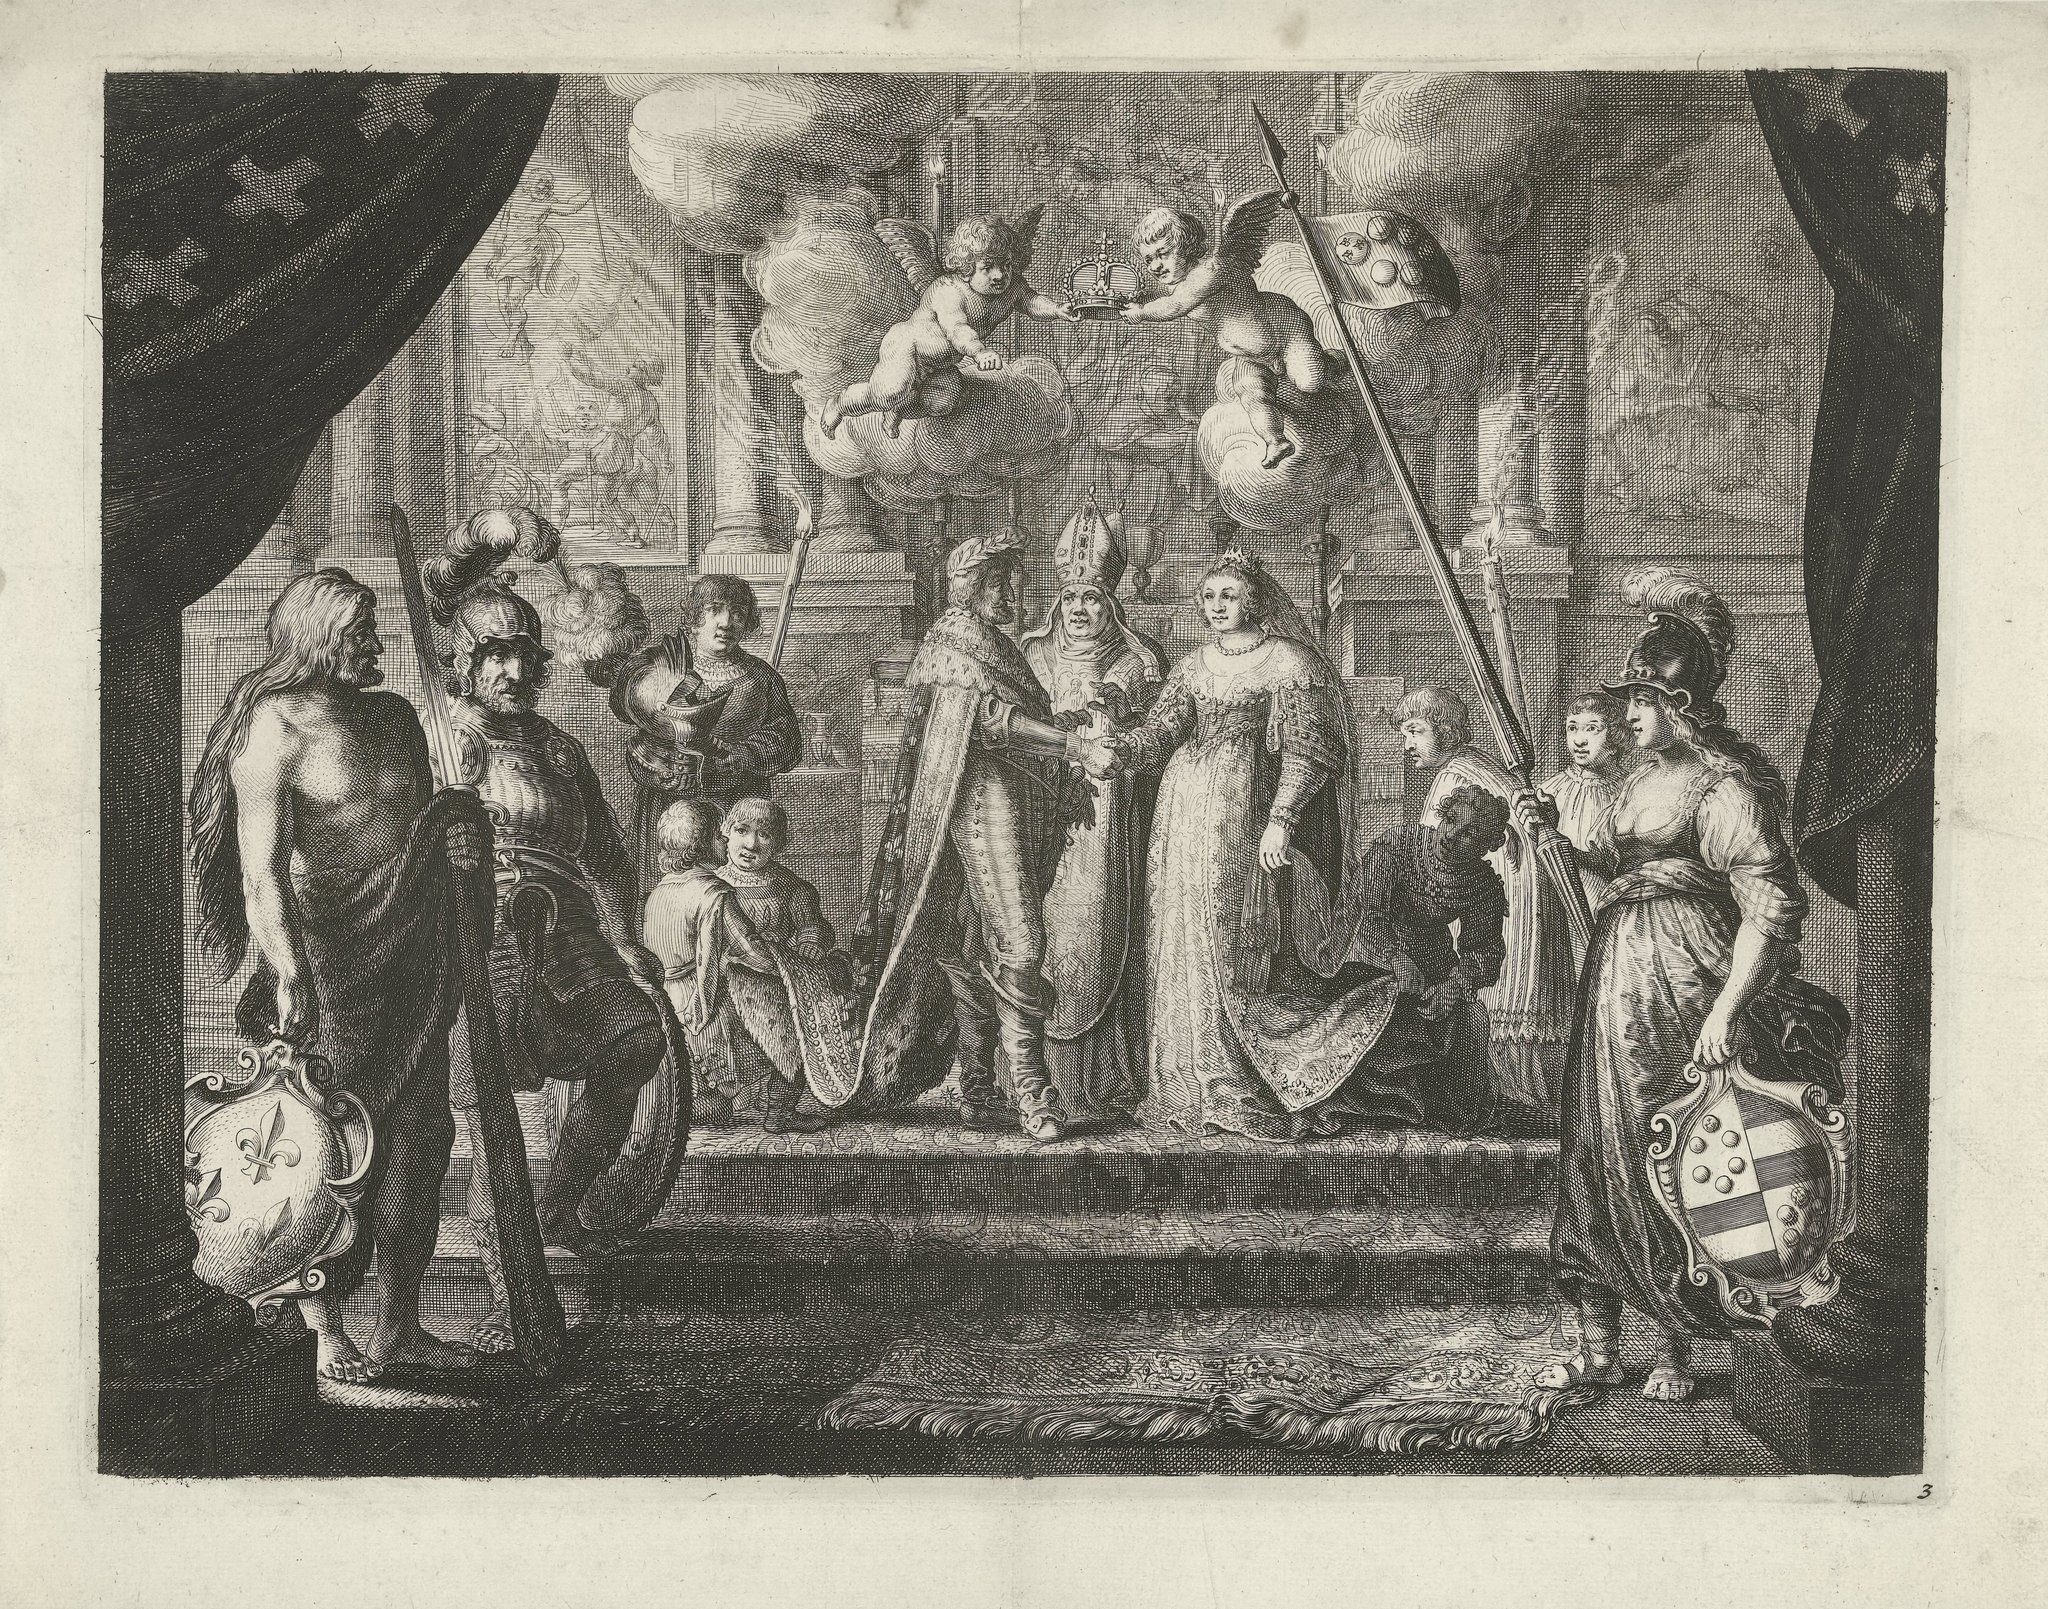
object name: print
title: Huwelijk van koning Hendrik IV van Frankrijk met Maria de' Medici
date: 1638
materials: paper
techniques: engraving, etching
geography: amsterdam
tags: cologne, print maker, maria de' medici, paris, hendrik iv (koning van frankrijk en navarra), triumphal entry and public reception, pageant, 'entrée solennelle', 'joyeuse entrée', blessing the married couple, (civil) marriage ceremonies, amsterdam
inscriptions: collector's mark: Lugt 240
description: Prent ook gebruikt in:* Baerle, Caspar van. Medicea hospes, sive descriptio publicae gratulationis, qua Serenissimam, Augustissimamque Reginam, Mariam de Medicis (…). Amsterdam: Johannes en Cornelis Willemsz. Blaeu, 1638. En in: Baerle, Caspar van. Marie de Medicis, entrant dans Amsterdam : ou, histoire de la reception faicte à la Reyne Mere du Roy tres-Chrestien (…). Amsterdam: Johannes en Cornelis Willemsz. Blaeu, 1638. En in: Baerle, Caspar van en Joost van den Vondel. Blyde inkomst der allerdoorluchtighste koninginne, Maria de Medicis t' Amsterdam. Vertaelt uit het Latijn (…). Amsterdam: Johannes en Cornelis Willemsz. Blaeu, 1639. * Doorgaans zijn de prenten in de bovengenoemde publicaties rechtsonder genummerd (van de huidige prent is dat de derde bekende staat). Maar er zijn ook exemplaren waarin eerdere, ongenummerde, staten van de prenten (van de huidige prent de eerste en tweede bekende staat) zijn ingebonden.